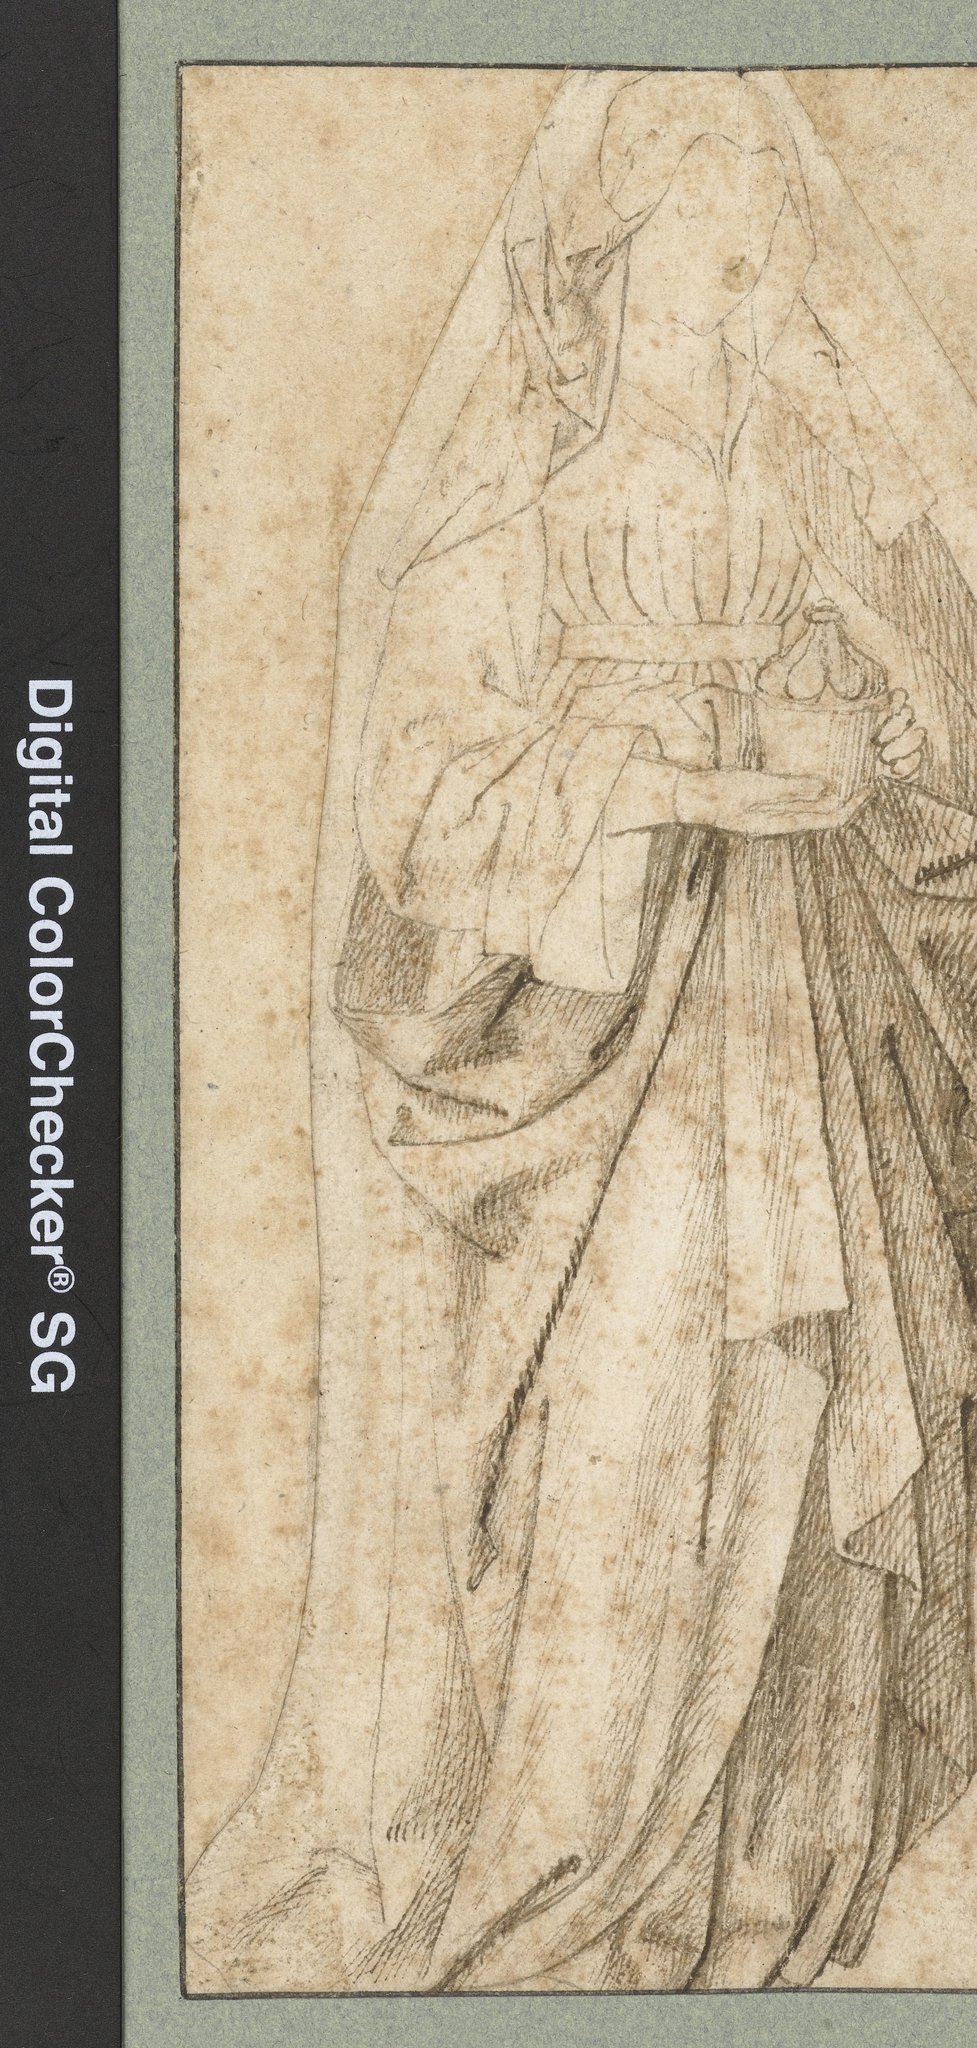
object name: drawing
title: Maria Magdalena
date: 1440-1485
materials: ink, paper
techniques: pen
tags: the penitent harlot mary magdalene; possible attributes: book (or scroll), crown, crown of thorns, crucifix, jar of ointment, mirror, musical instrument, palm-branch, rosary, scourge